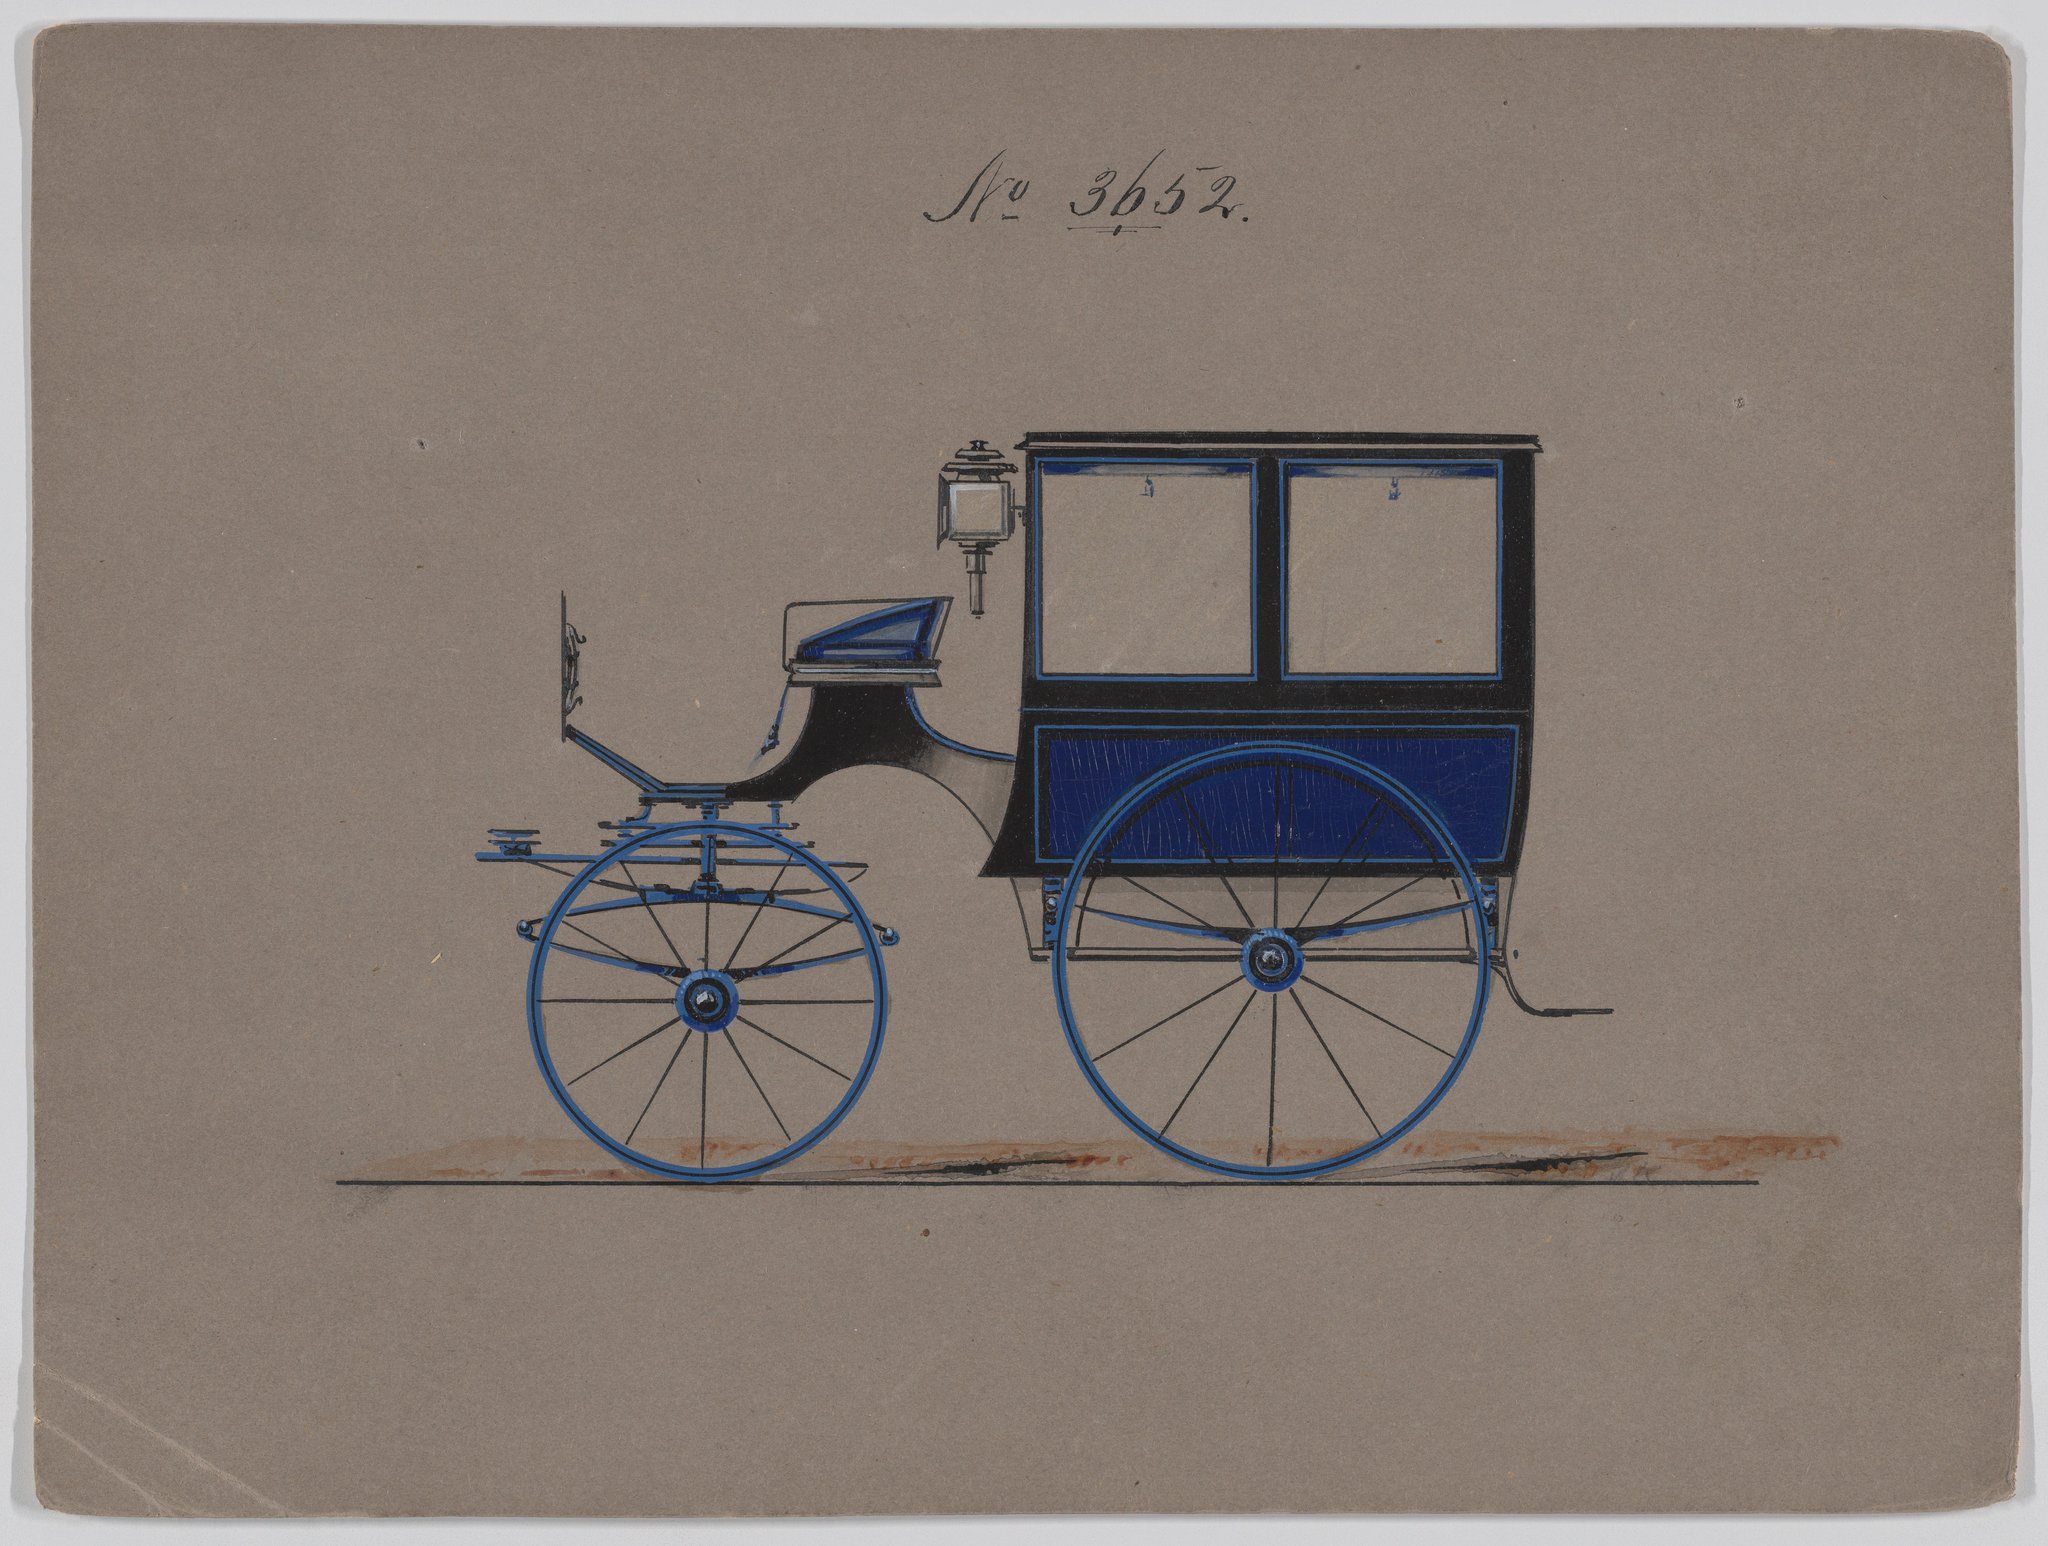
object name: drawing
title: Design for Omnibus or Wagonette, no. 3652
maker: brewster & co.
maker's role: manufacturer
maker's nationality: american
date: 1881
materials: gouache, gum arabic, ink, watercolor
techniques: pen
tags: carriages